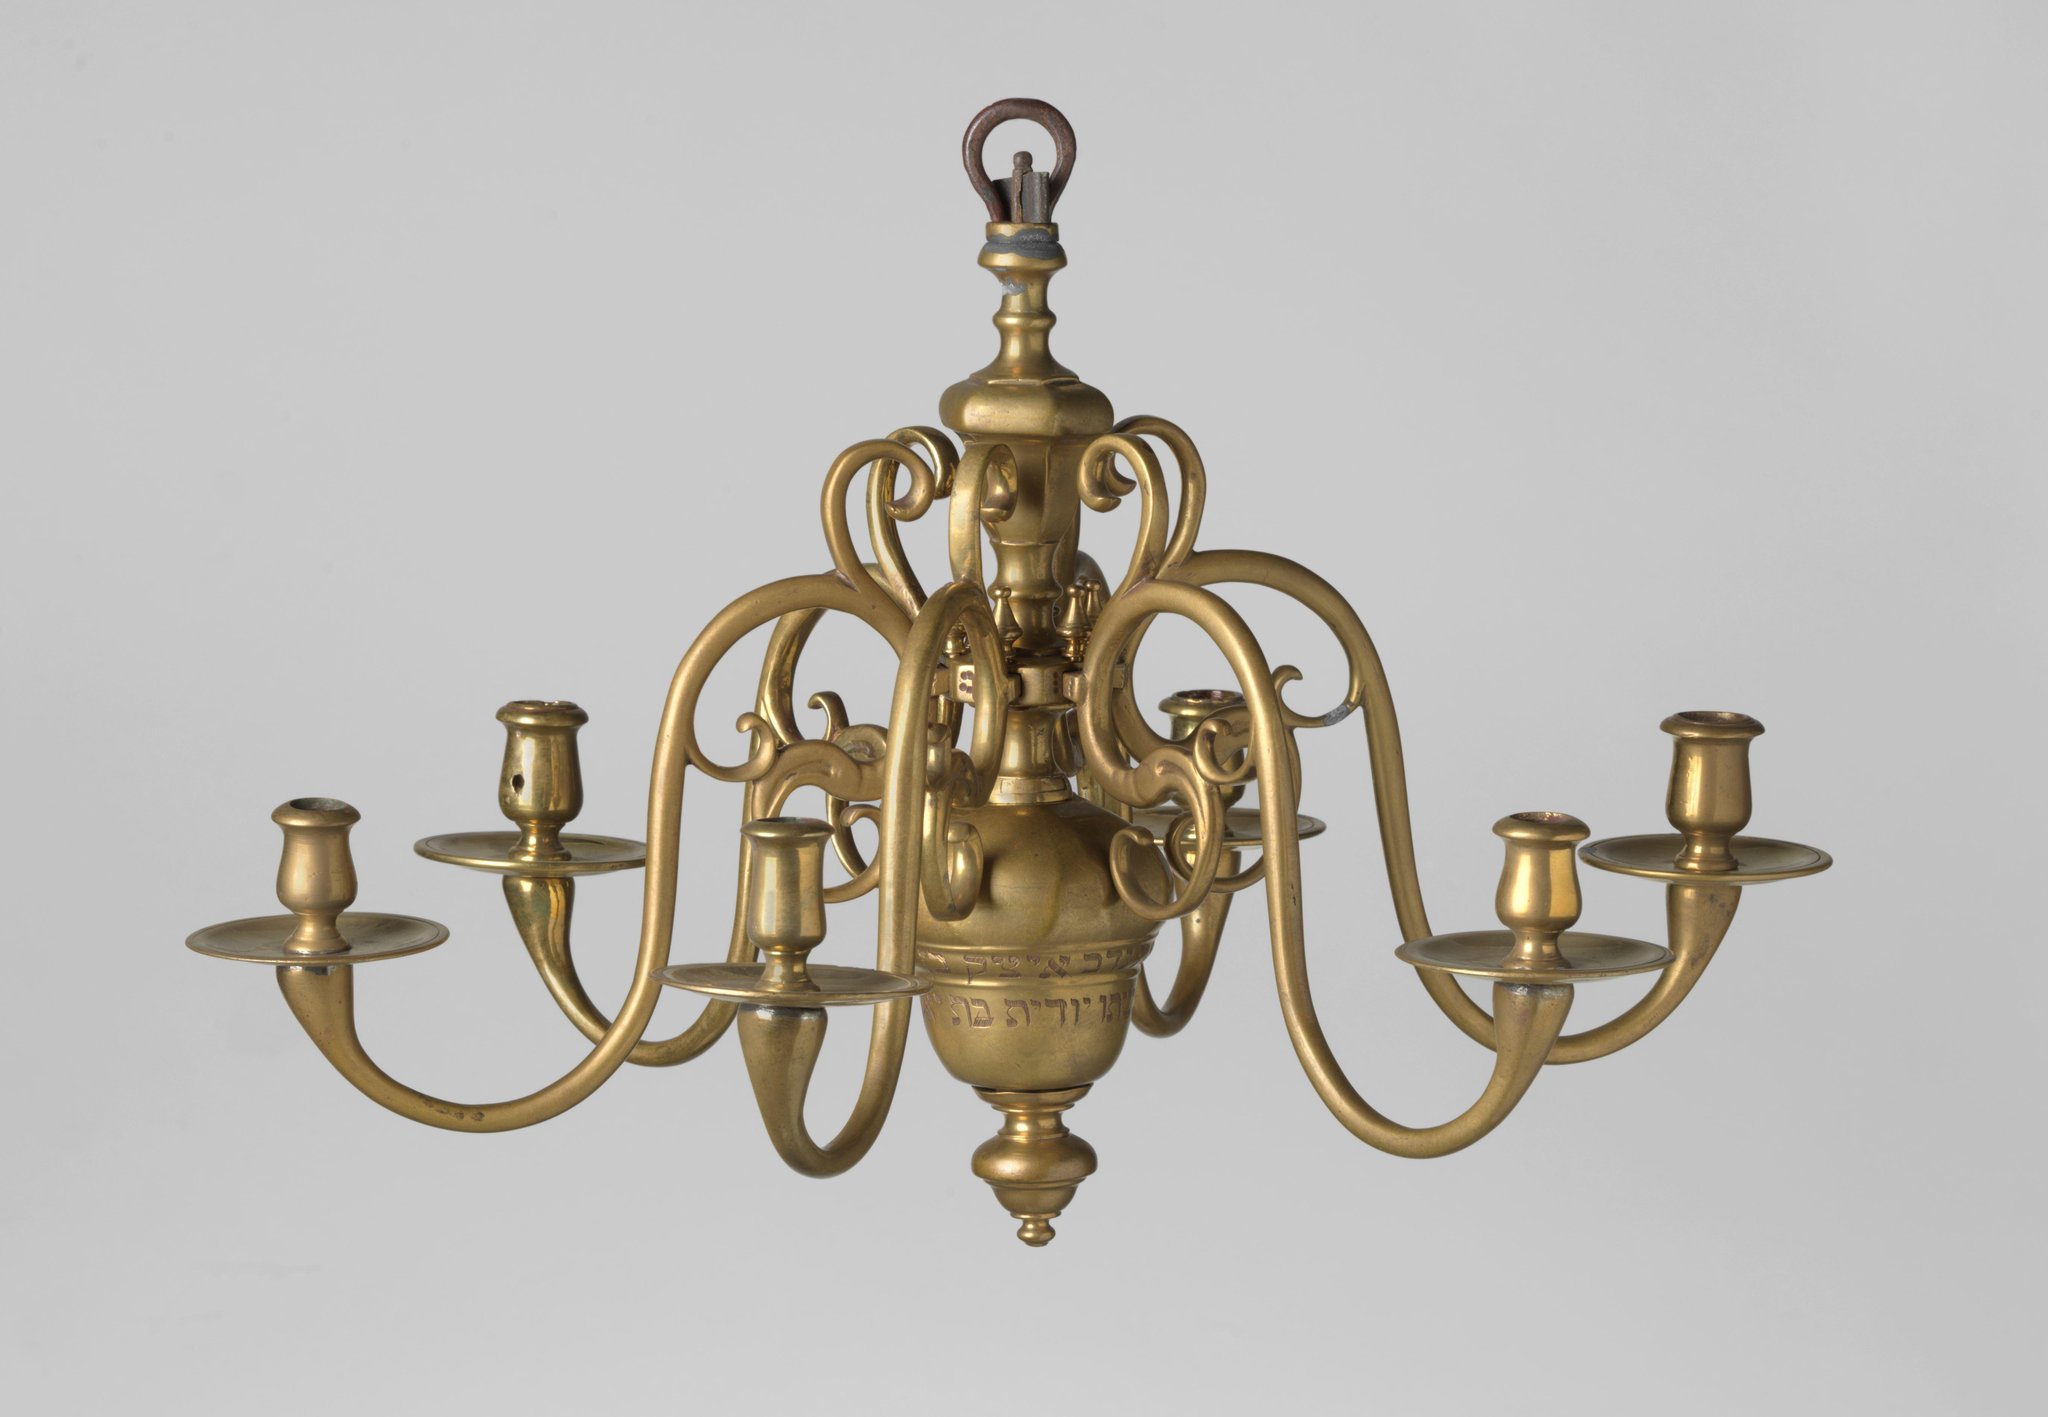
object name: chandelier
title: Arm met kaarsenhouder van kaarsenkroon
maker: Anonymous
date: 1795-1800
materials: brass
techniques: casting, screwed, turning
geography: amsterdam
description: De S-vormige arm heeft een krul op het eind aan de stamzijde en gaat naar buiten toe over in een verdikking met schroefgat. Daarin is de kaarsenhouder met de vetvanger vastgezet. De ronde houder heeft een holrond voetstuk, versmalt zich naar boven toe en heeft vervolgens een uitstekende rand. De vetvanger heeft aan de bovenkant een gegroefde ring. Dit is de vijfde arm, genummerd met 5 ronde punten.